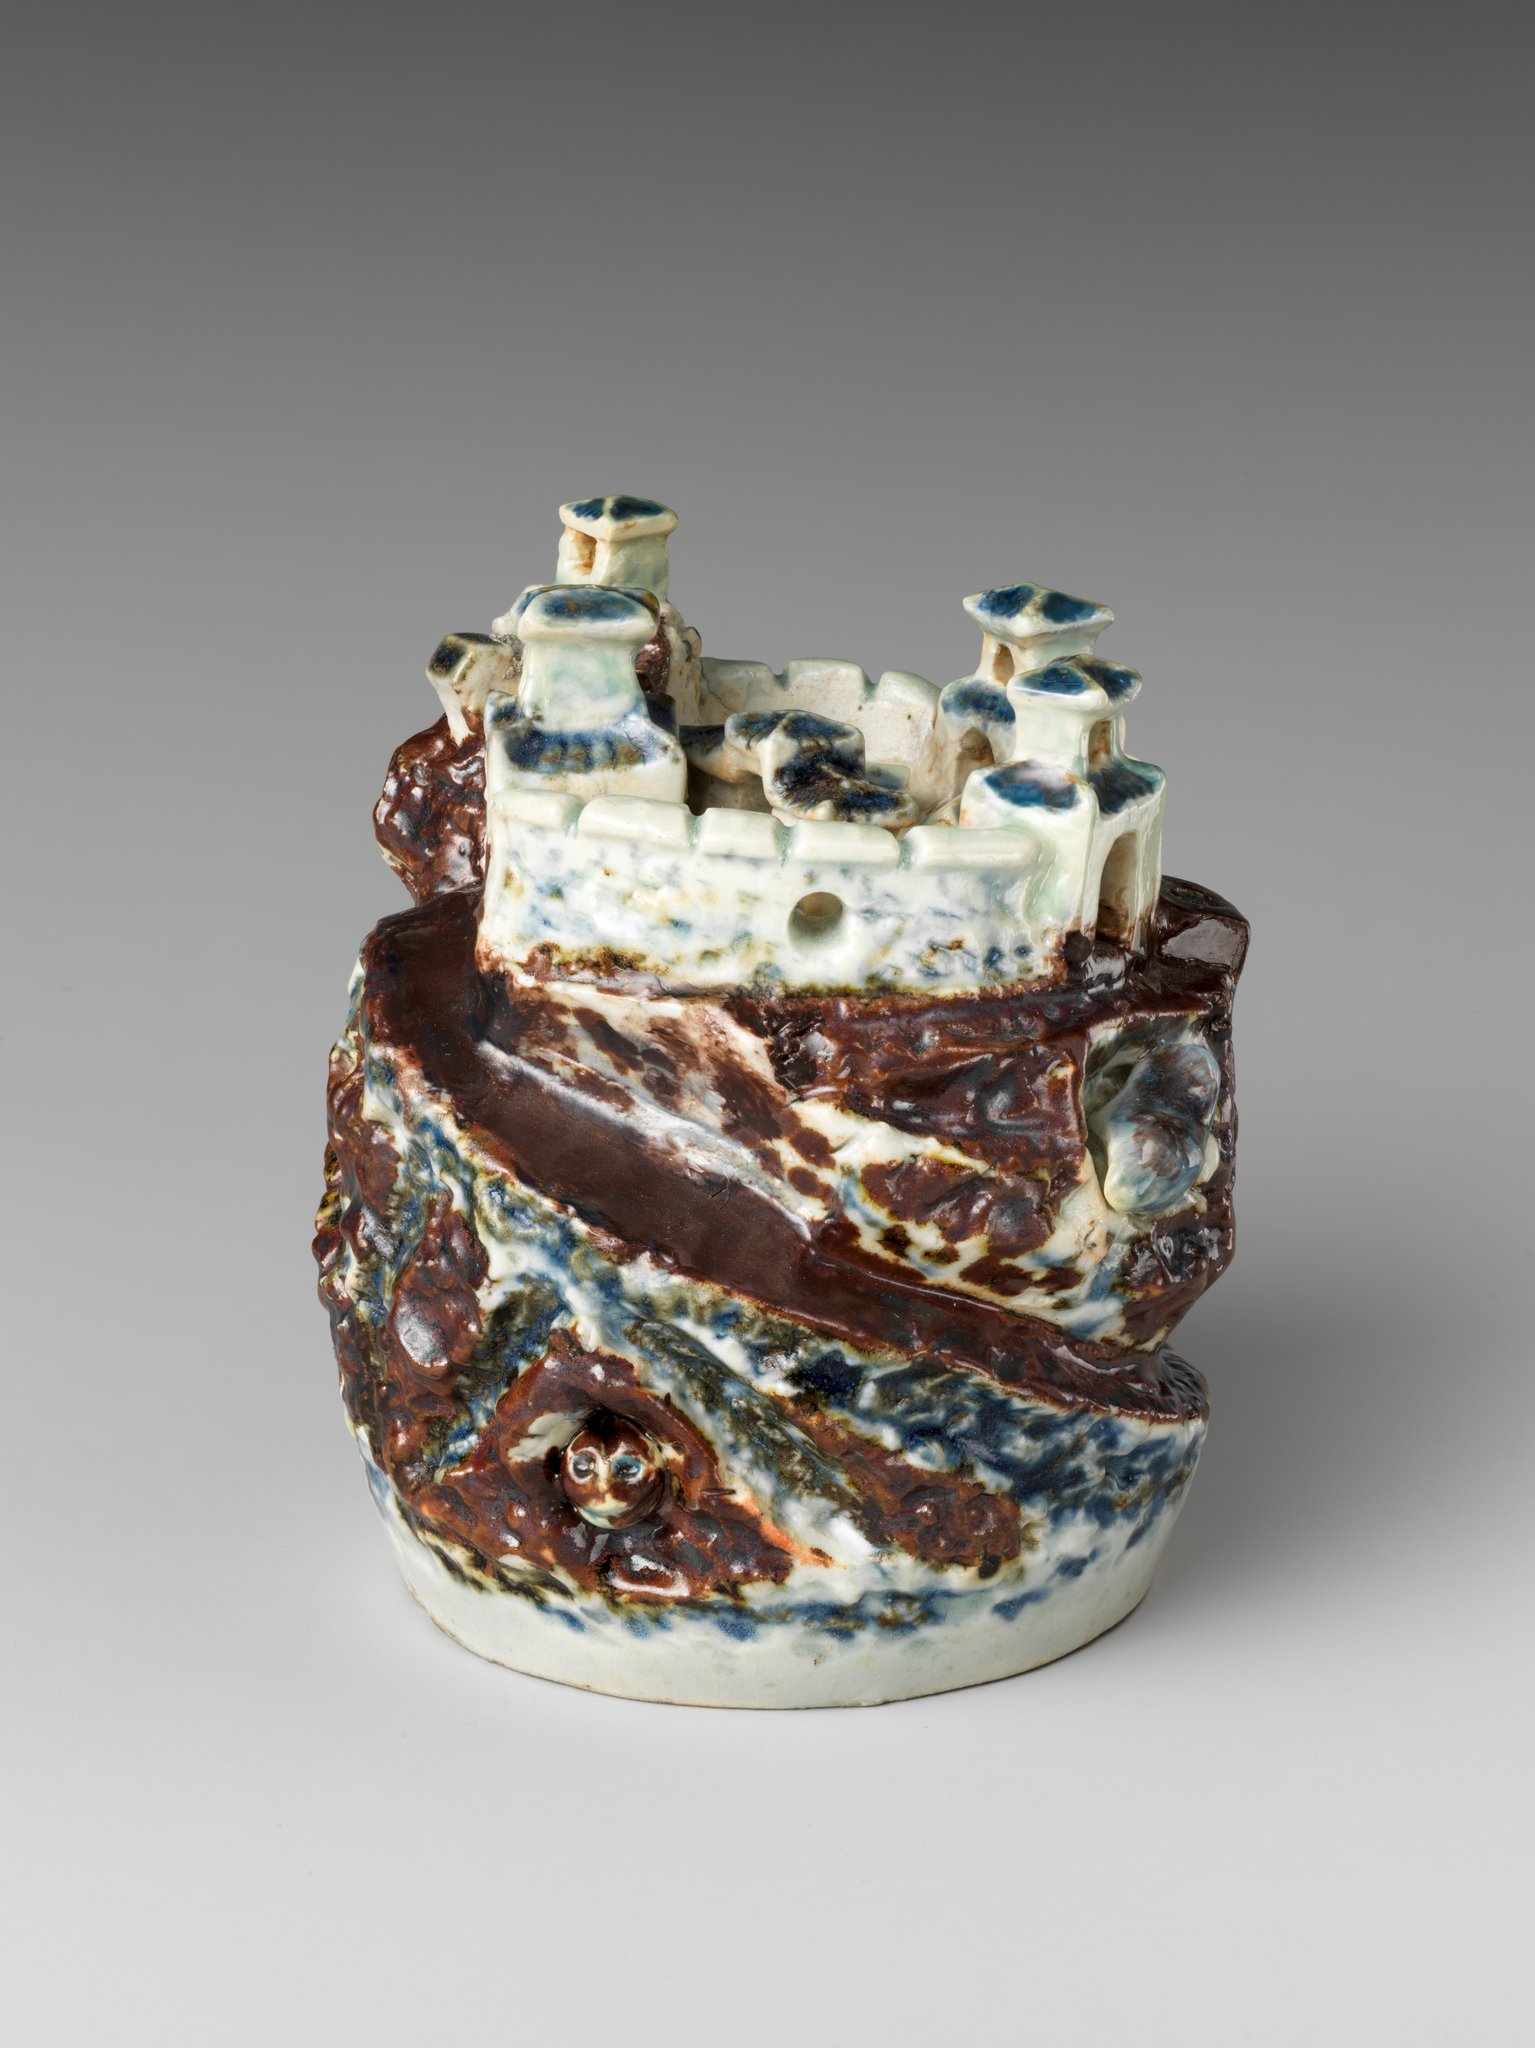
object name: water dropper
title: Water dropper in the shape of a mountain citadel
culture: korean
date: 1801-1900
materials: cobalt, copper, porcelain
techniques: painting, underglaze